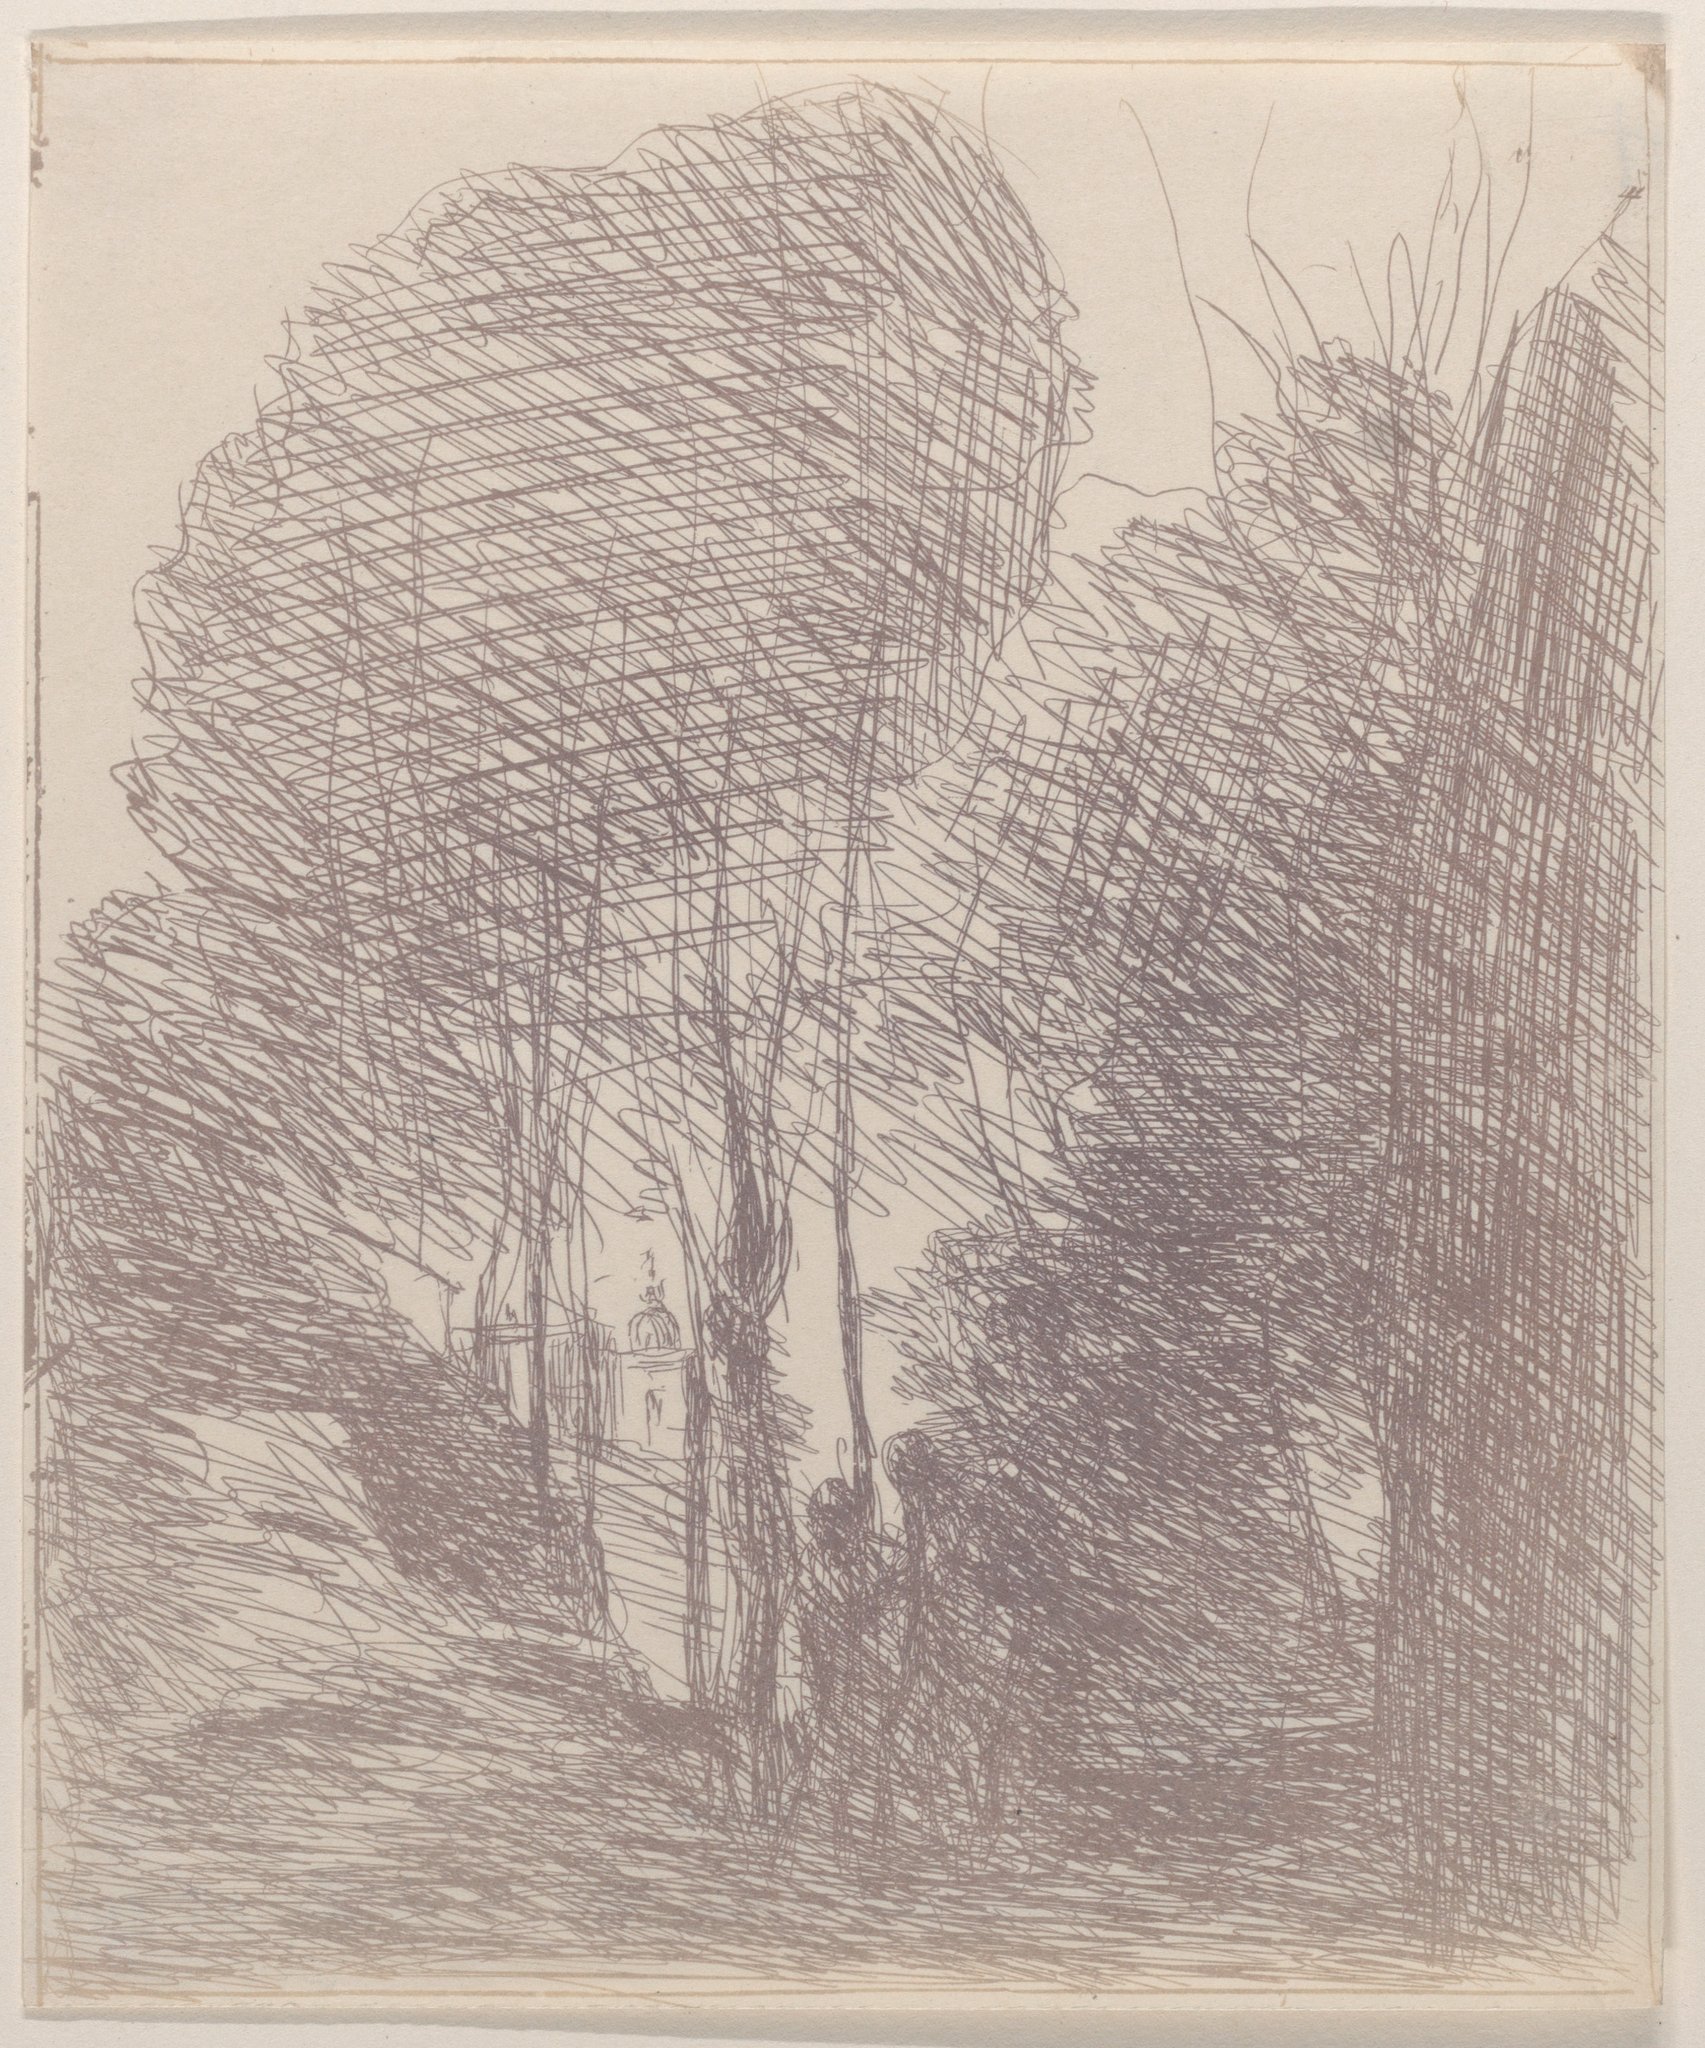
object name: print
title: Souvenir de la Villa Pamphili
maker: jean-baptiste-camille corot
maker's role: artist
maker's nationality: french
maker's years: 1796-1875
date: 1871